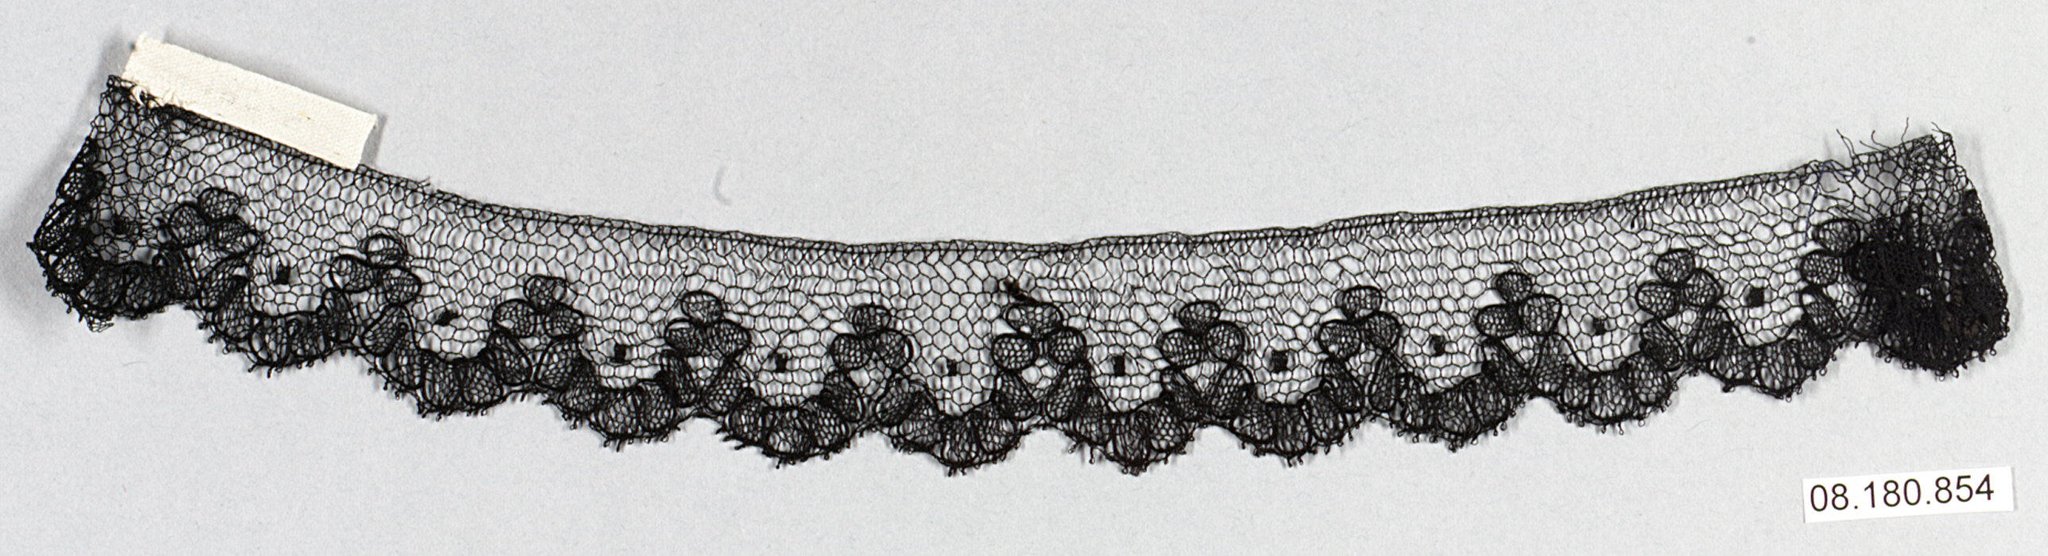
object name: fragment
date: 1801-1900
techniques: lace